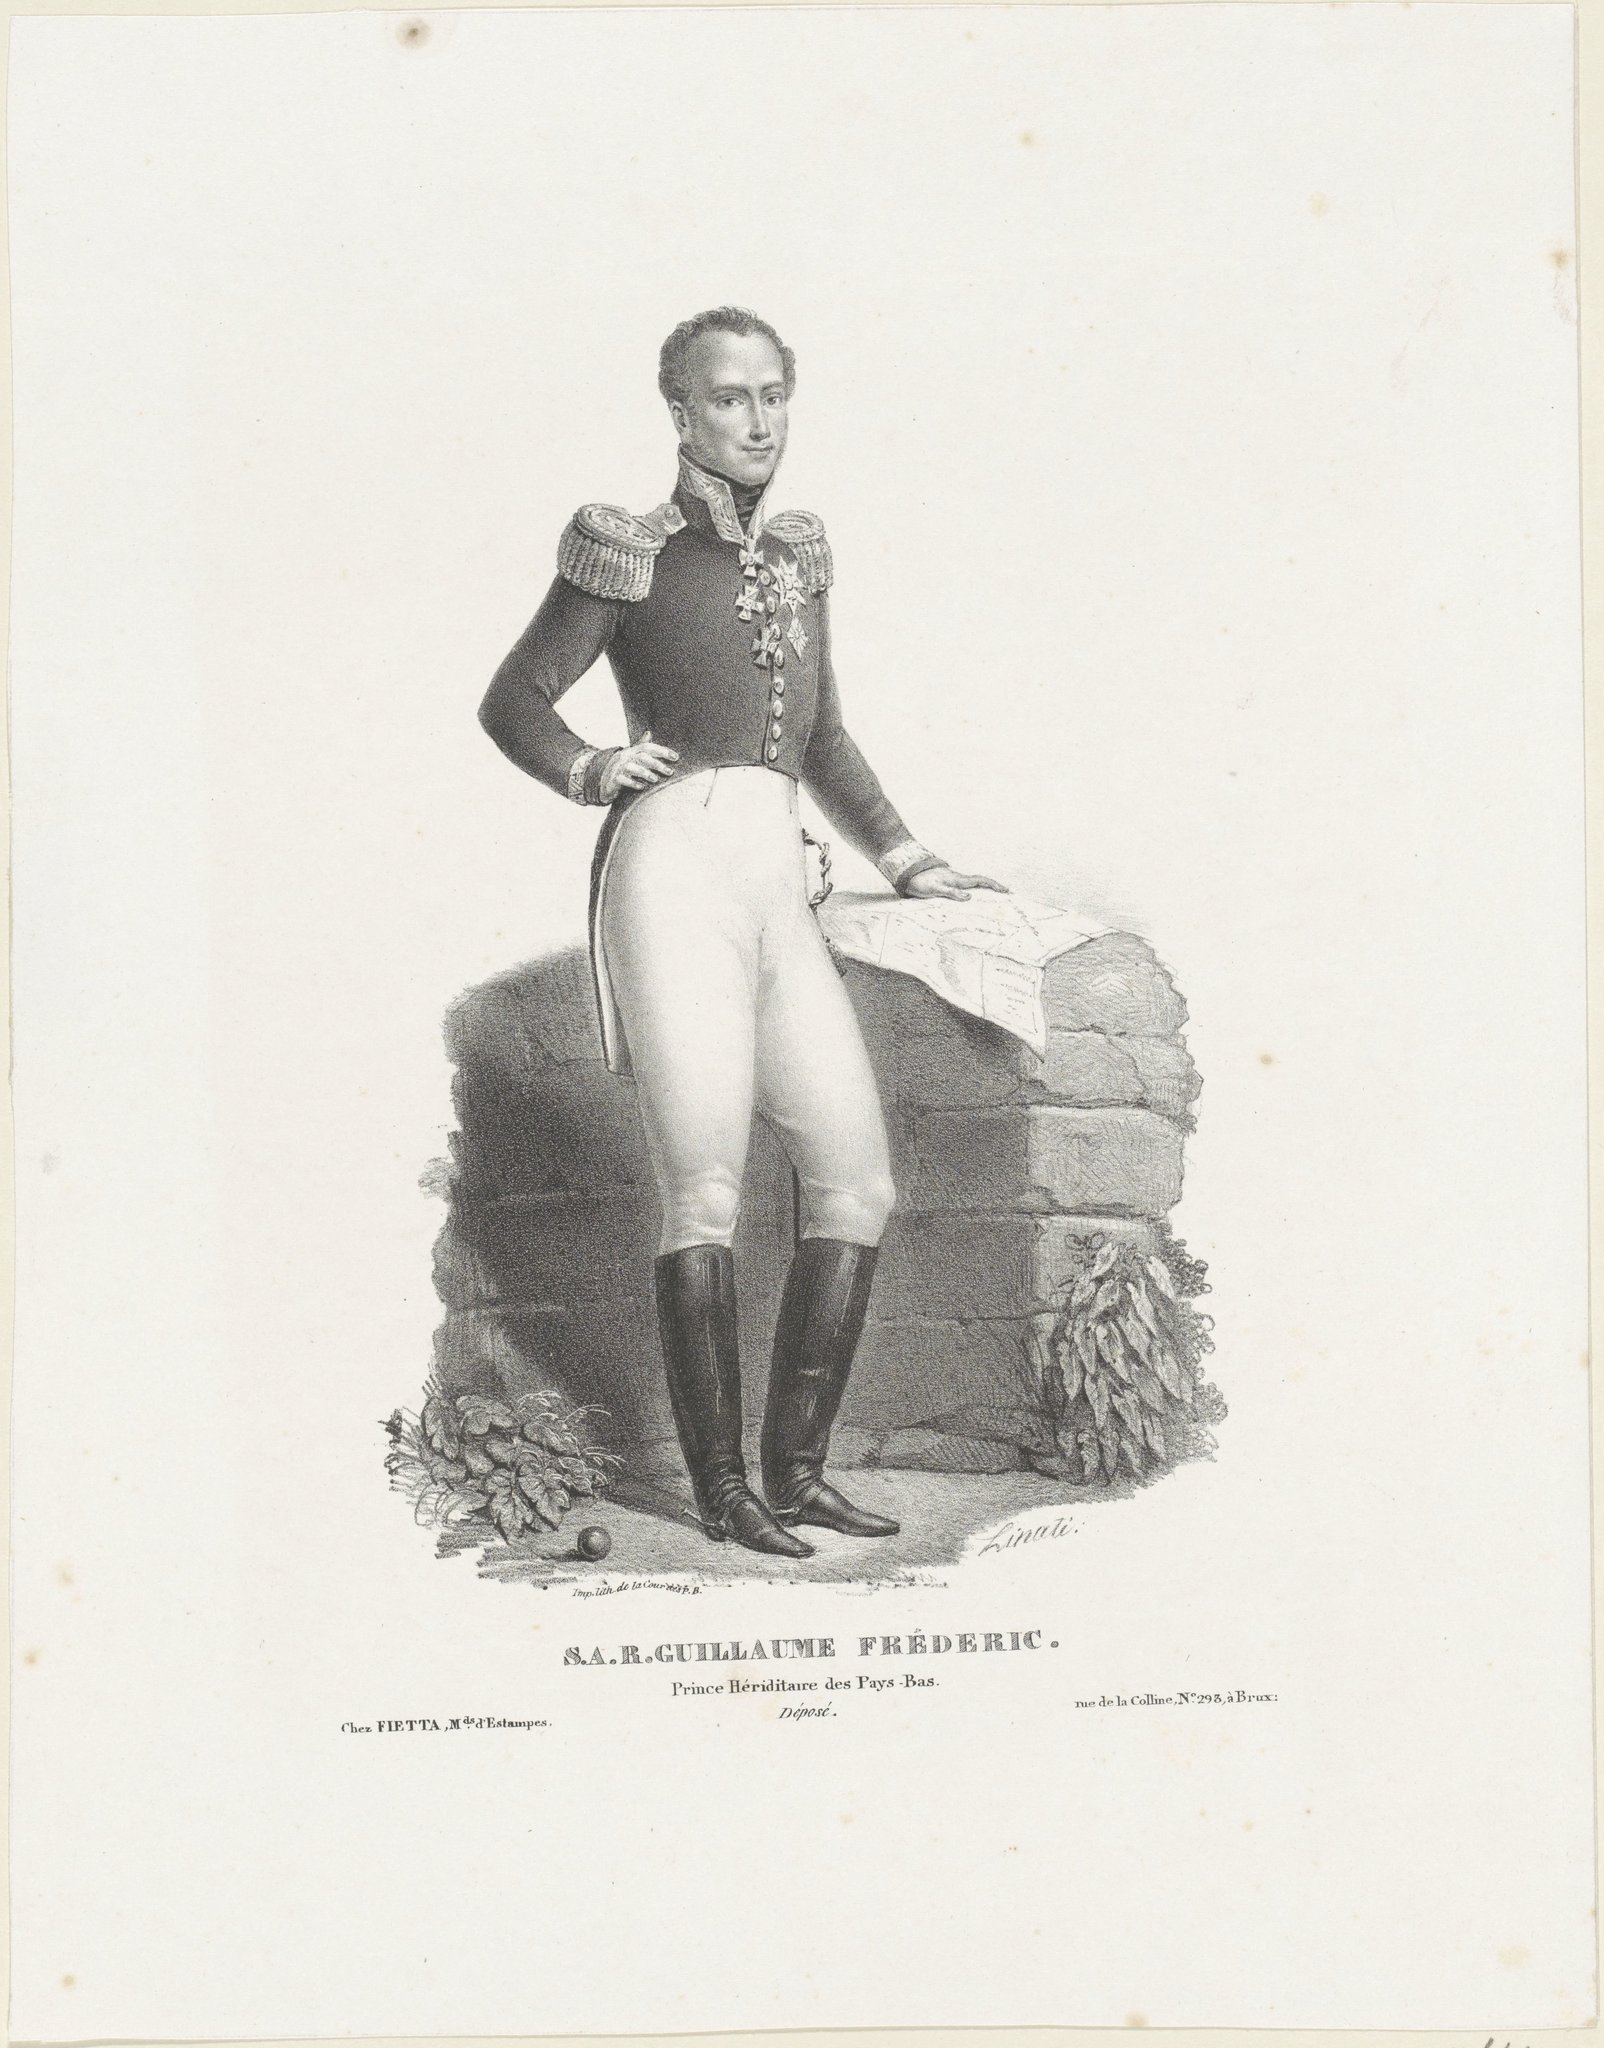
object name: print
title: Portret van Willem II, koning der Nederlanden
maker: claudio linati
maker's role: print maker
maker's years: 1790-1832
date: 1810-1829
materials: paper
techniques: lithograph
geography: brussels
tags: william ii of the netherlands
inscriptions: octrooivermelding, gedrukt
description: De hier vermelde titel verwijst naar de hoogst verkregen titel van de geportretteerde, niet per se naar de titel die de geportretteerde op deze voorstelling draagt.